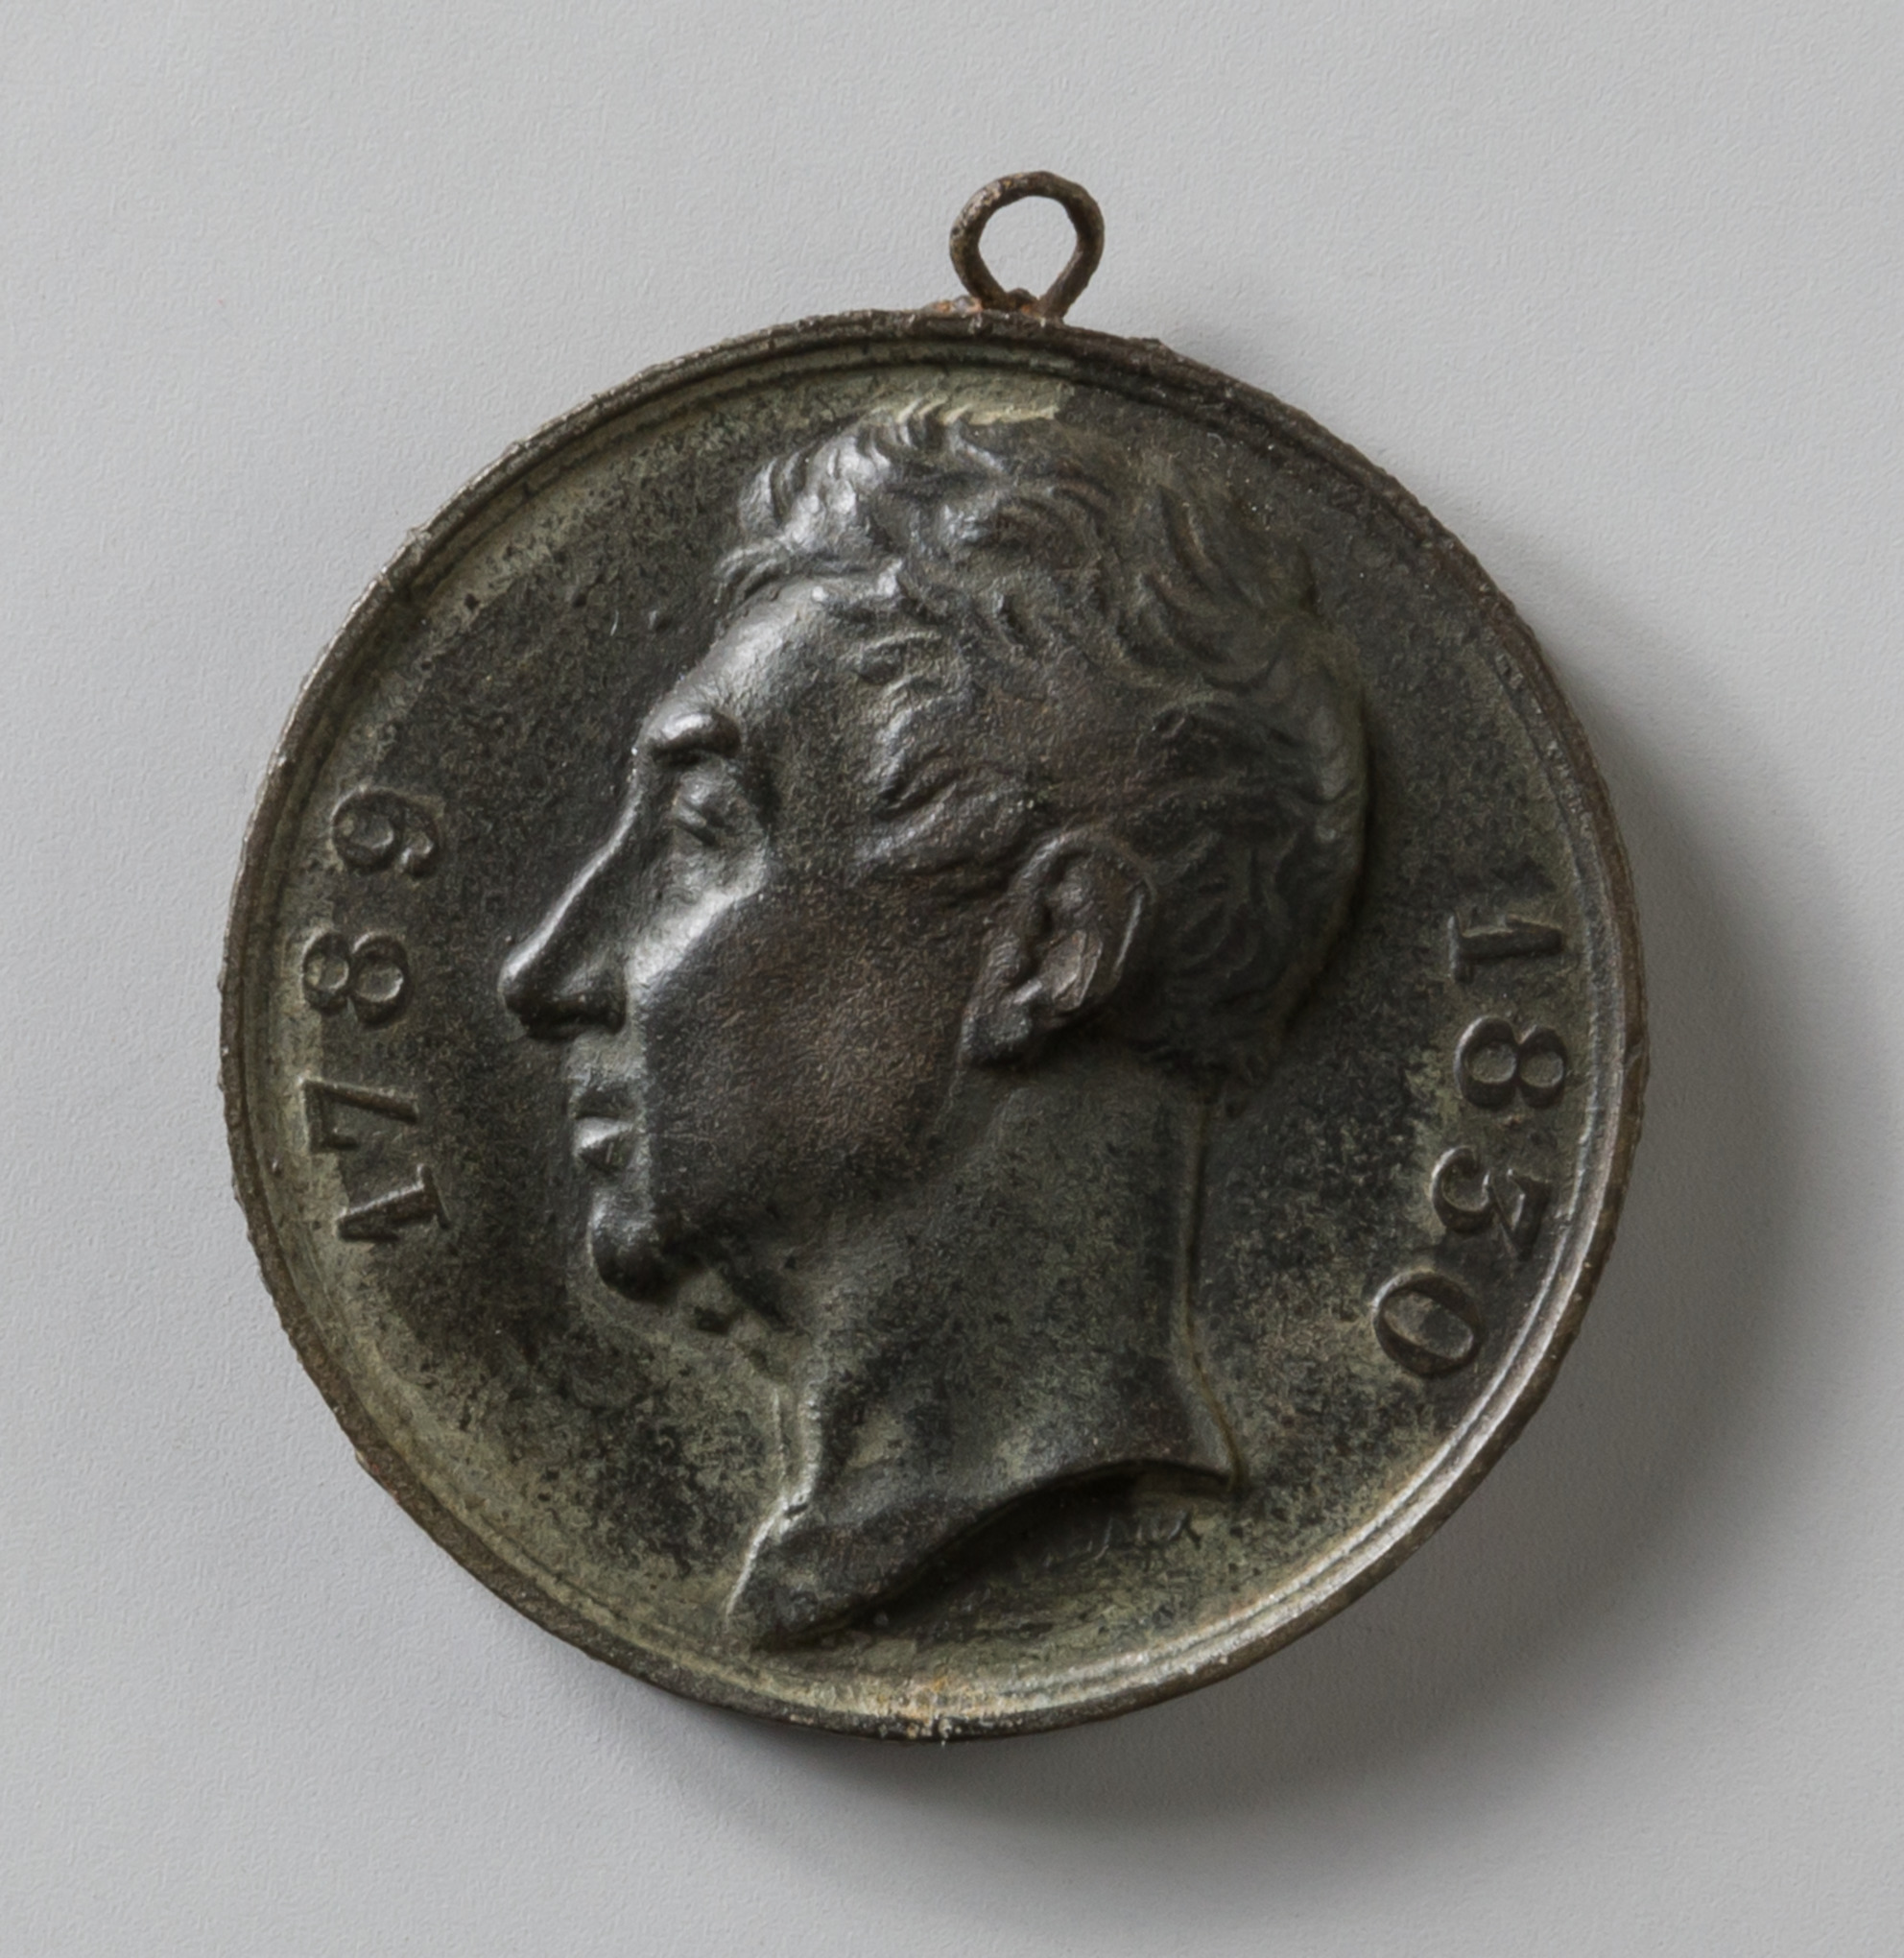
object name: medal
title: Medal of the Constituency of Meaux in Honor of Its Deputy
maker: jacques edouard gatteaux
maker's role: maker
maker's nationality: french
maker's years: 1788-1881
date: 1830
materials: iron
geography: france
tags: men,profiles